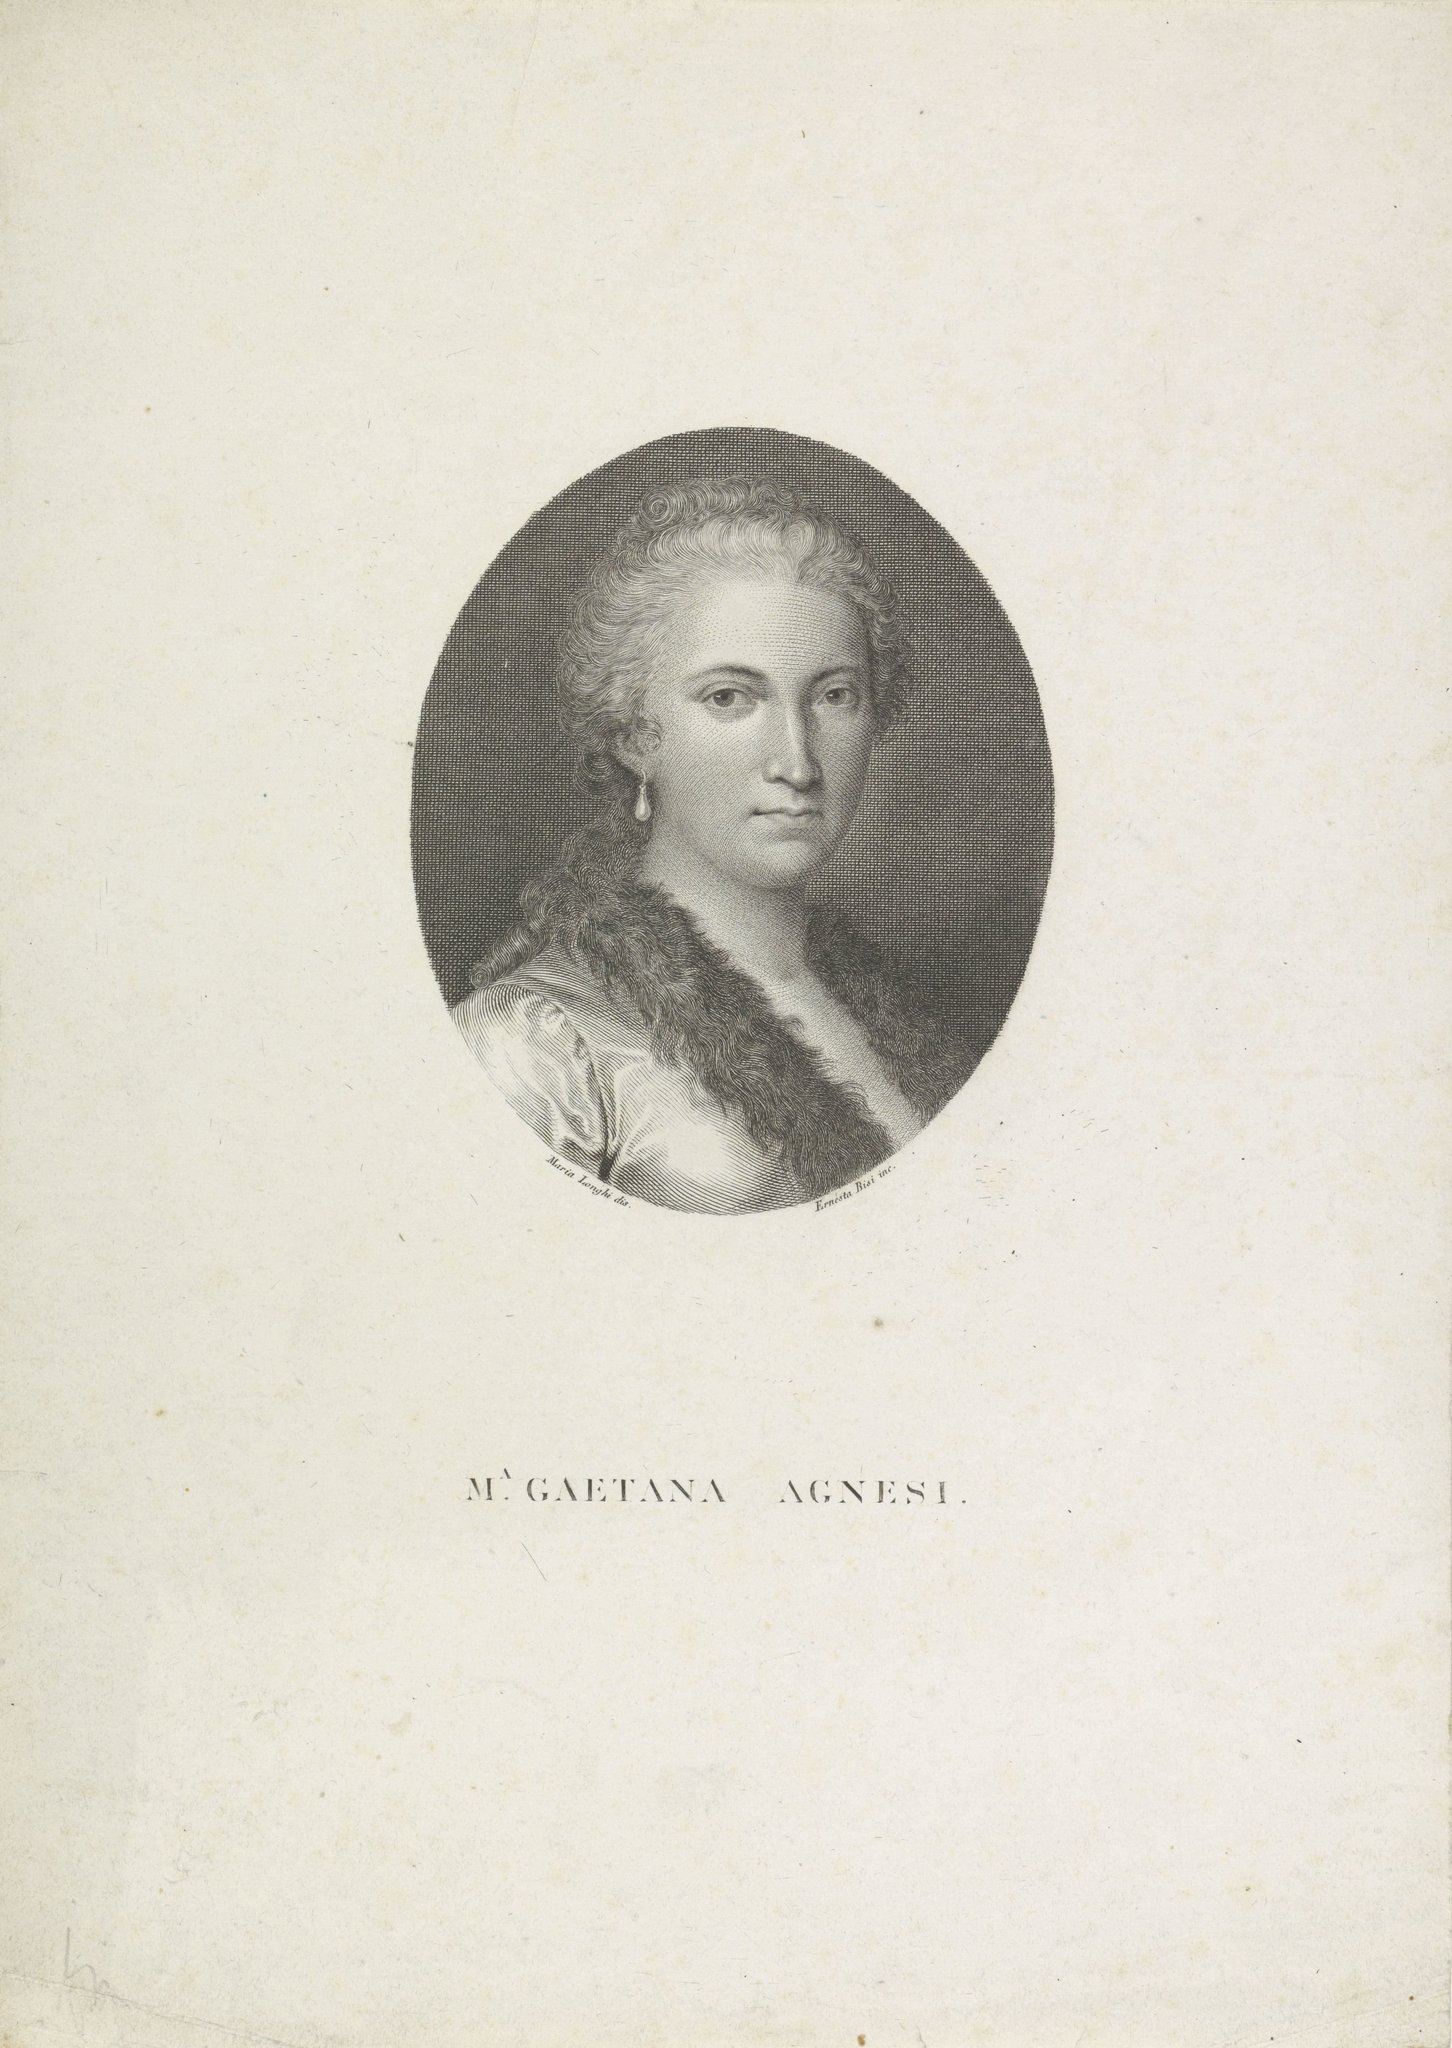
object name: print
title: Portret van Maria Gaetana Agnesi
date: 1798-1859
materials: paper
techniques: engraving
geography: milan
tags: historical persons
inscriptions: collector's mark: Lugt 2228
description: Deze prent maakt deel uit van een reeks portretprenten van onbekende omvang. De reeks is in meerdere staten uitgegeven. De eerste staat met enkel het portret in ovaal. Een tweede staat met naam van de geportretteerde in holle letters onder de voorstelling. Een derde staat met de naam van de geportretteerde in gevulde letters onder de voorstelling. En een vierde staat met een rechthoekig kader rondom het ovale portret.